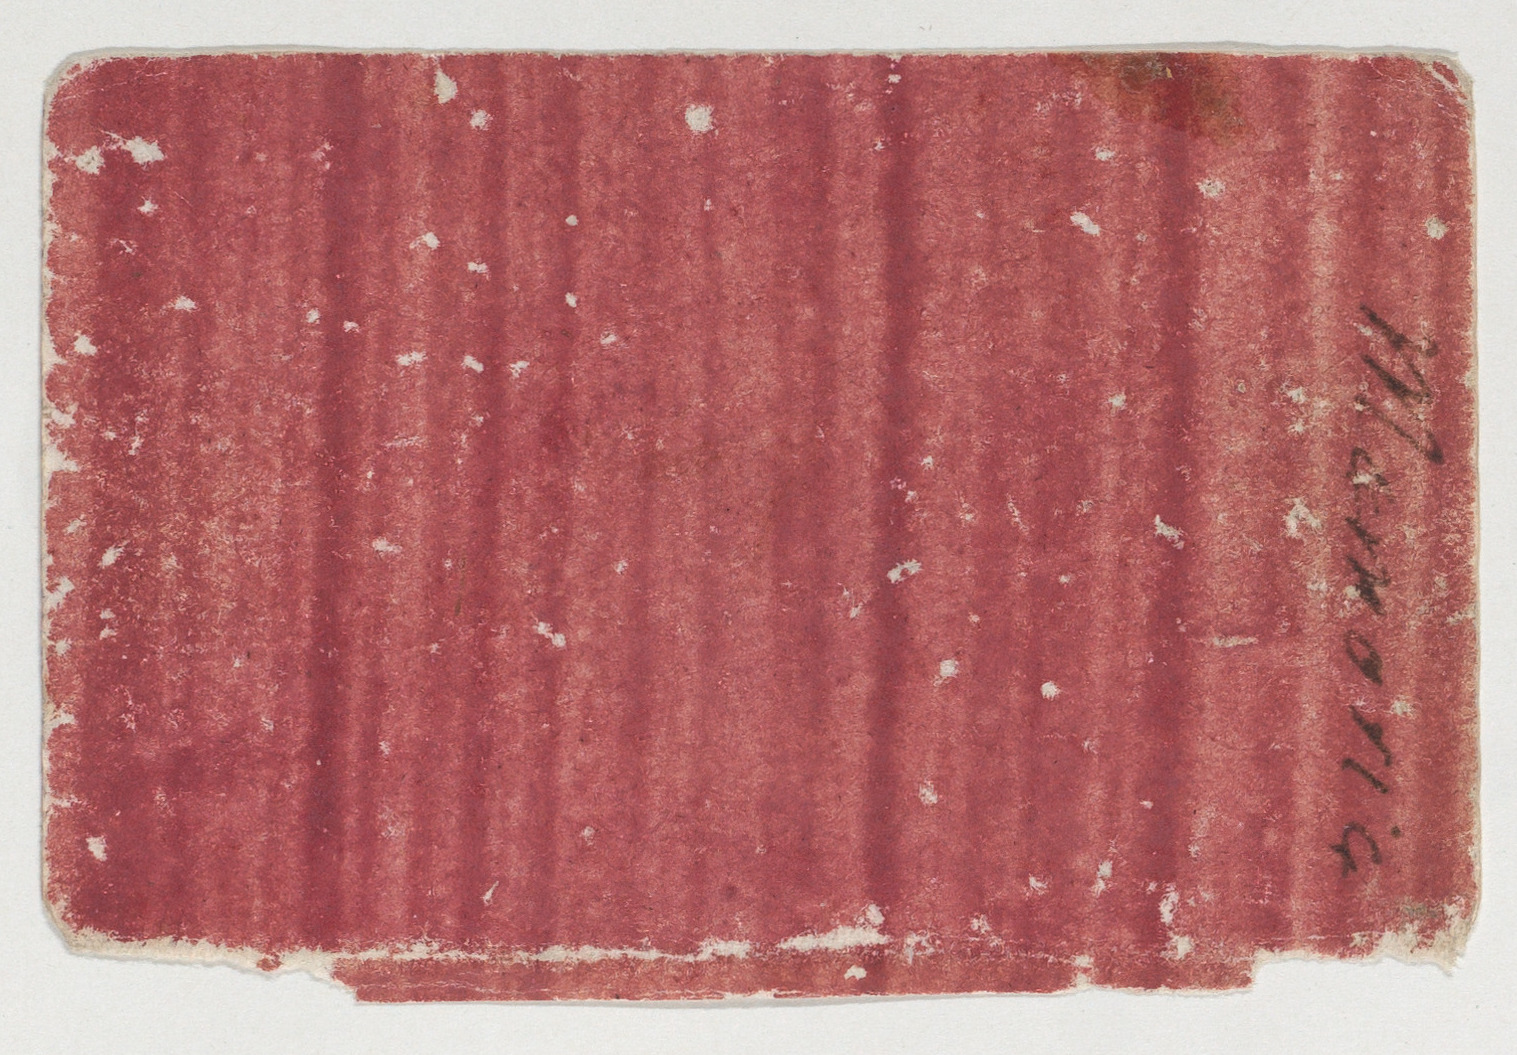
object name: print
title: Red paste paper with striping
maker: Anonymous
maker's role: artist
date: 1701-1800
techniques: relief print